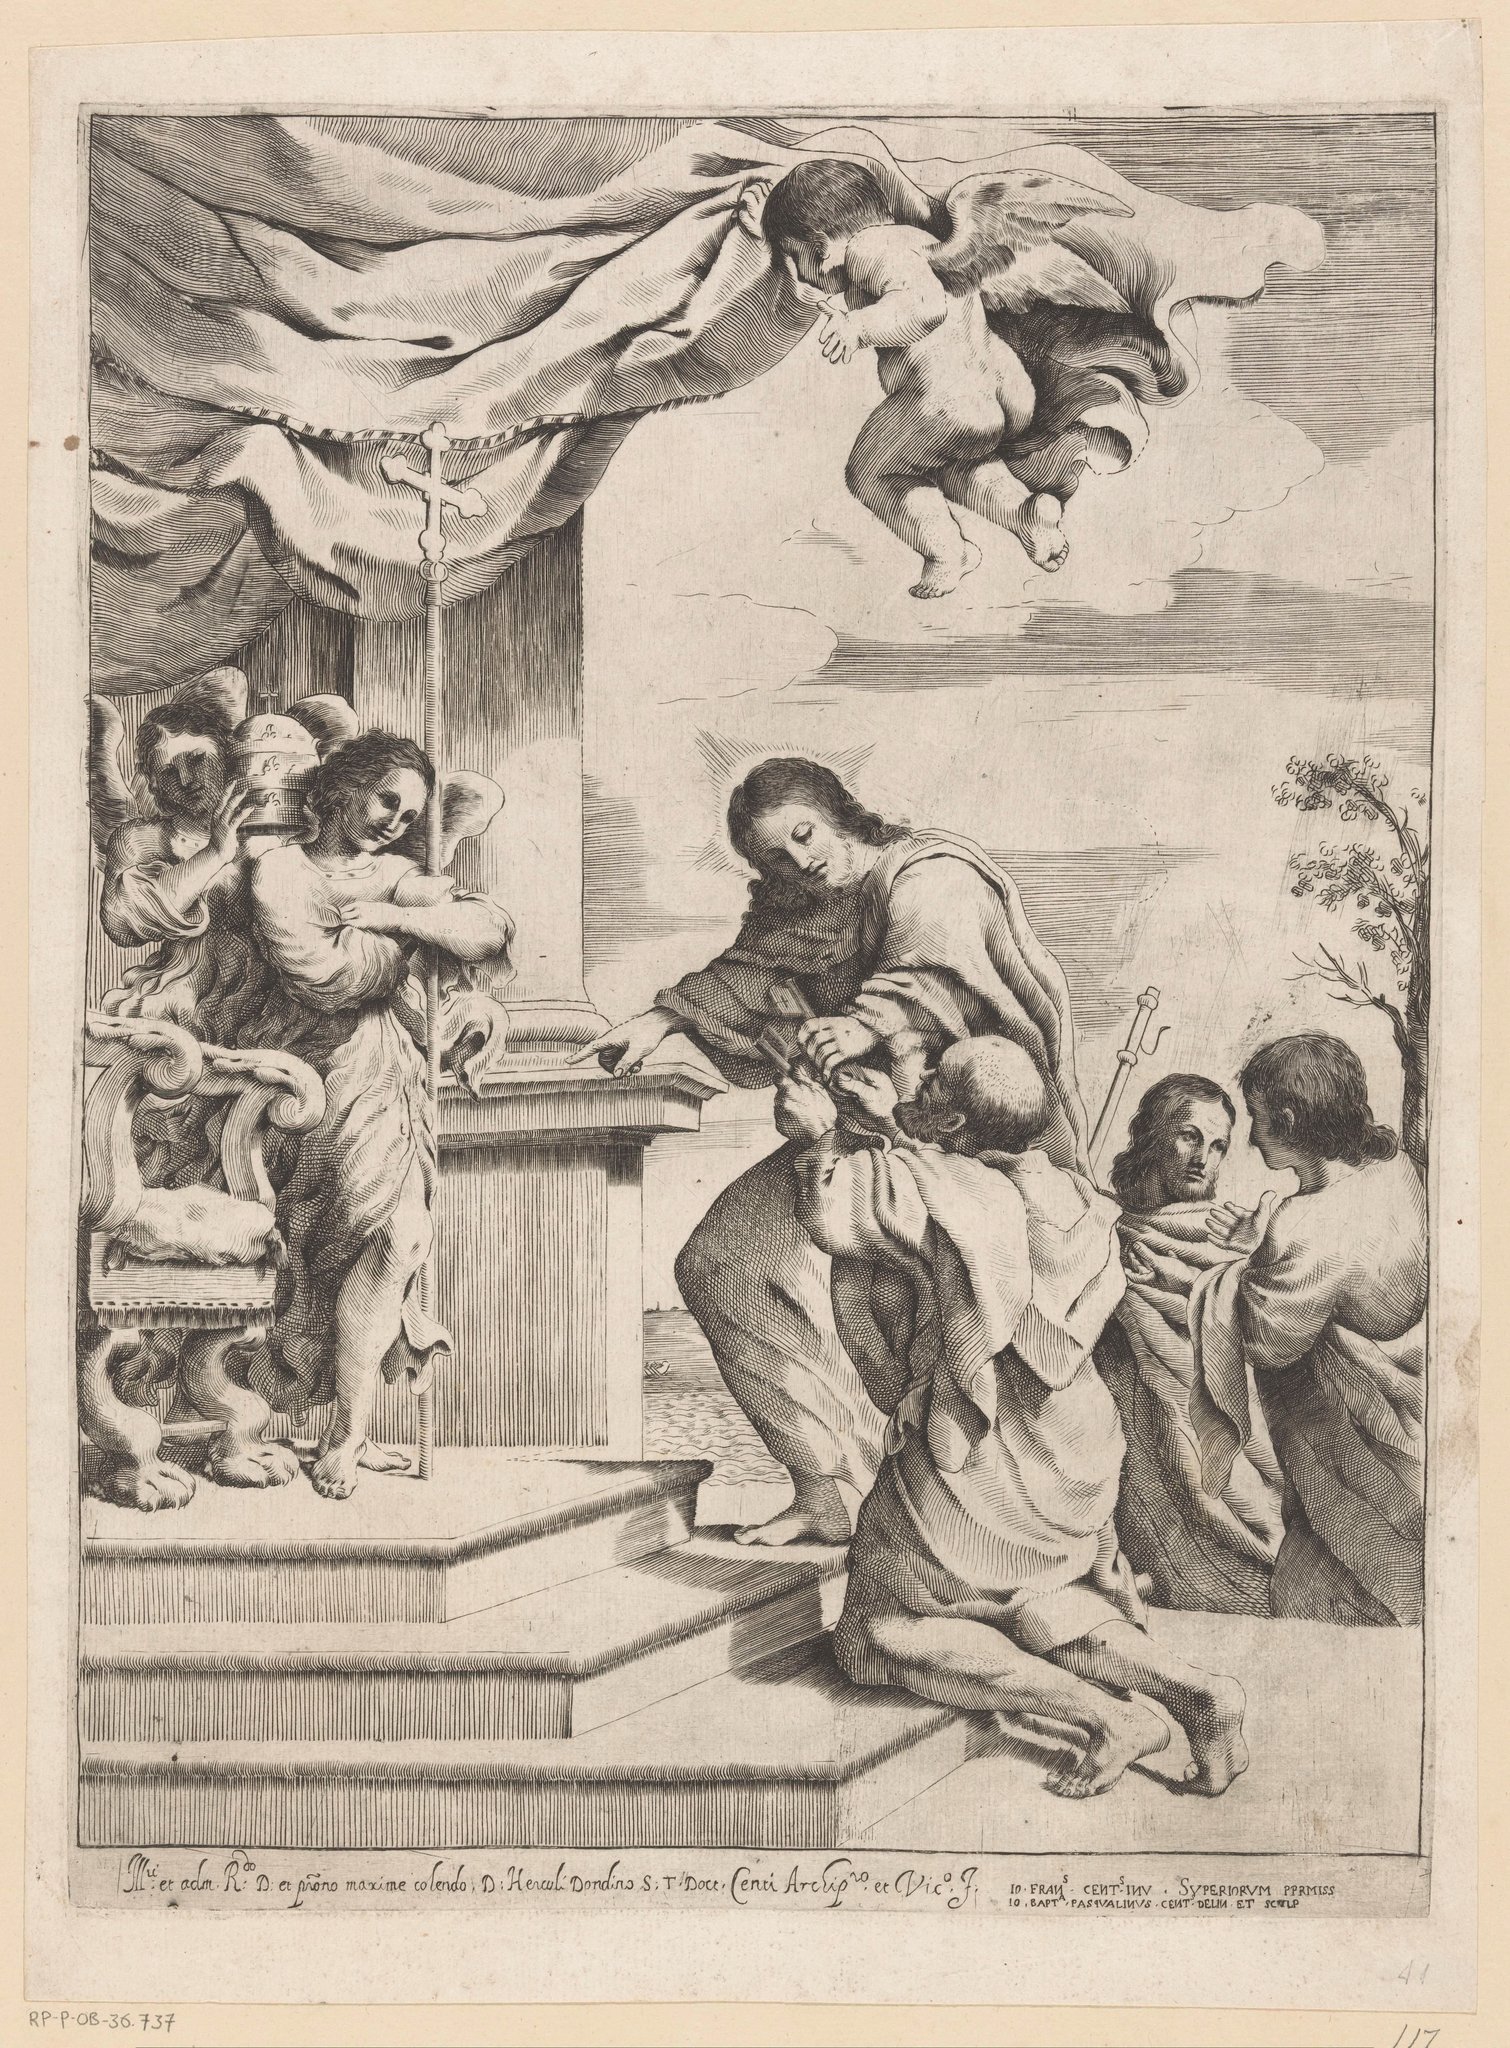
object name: print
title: Petrus ontvangt de sleutels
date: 1601-1634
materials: paper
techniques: engraving, intaglio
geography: italy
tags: canopy, baldachin, throne of st. peter, christ gives the keys of heaven to peter, insignia of the pope, e.g. tiara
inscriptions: collector's mark: Lugt 240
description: Petrus ontvangt de sleutels van het Koninkrijk der hemelen van Christus en wordt op zijn troon gewezen. Rechts staan twee figuren, mogelijk andere discipelen. Op de troon staan twee engelen met de Pauselijke Tiara (triregno) en de kruisstaf (ferula). Een derde engel houdt een doek omhoog bij wijze van baldakijn.